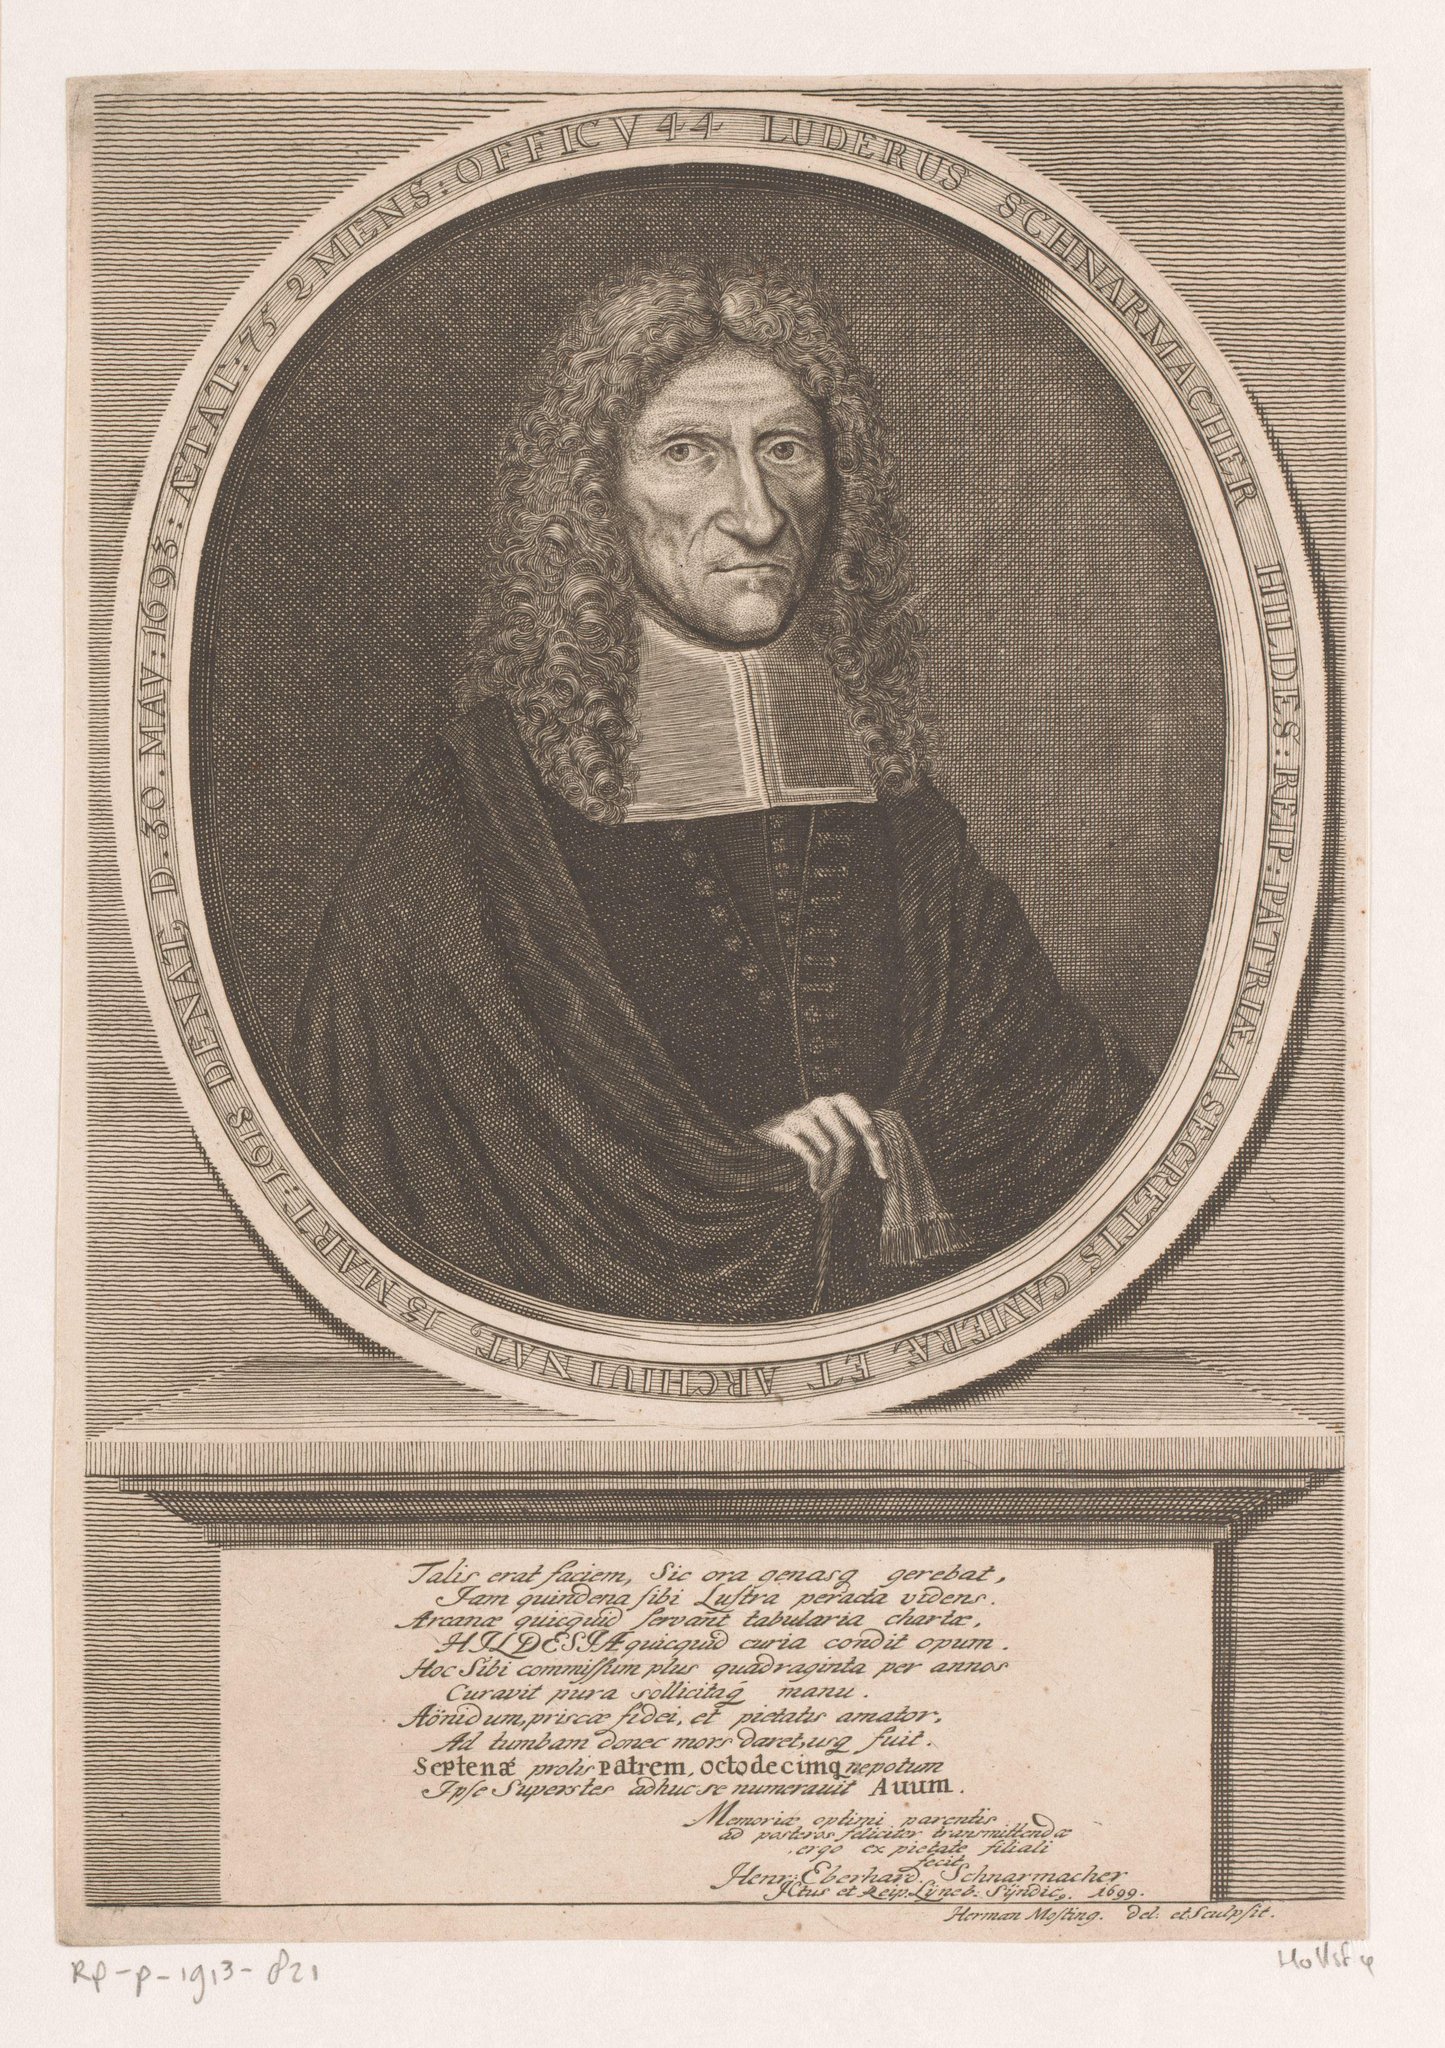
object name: print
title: Portret van Lüder Schnarmacher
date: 1693-1699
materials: paper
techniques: engraving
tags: historical persons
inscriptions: collector's mark: Lugt 2228